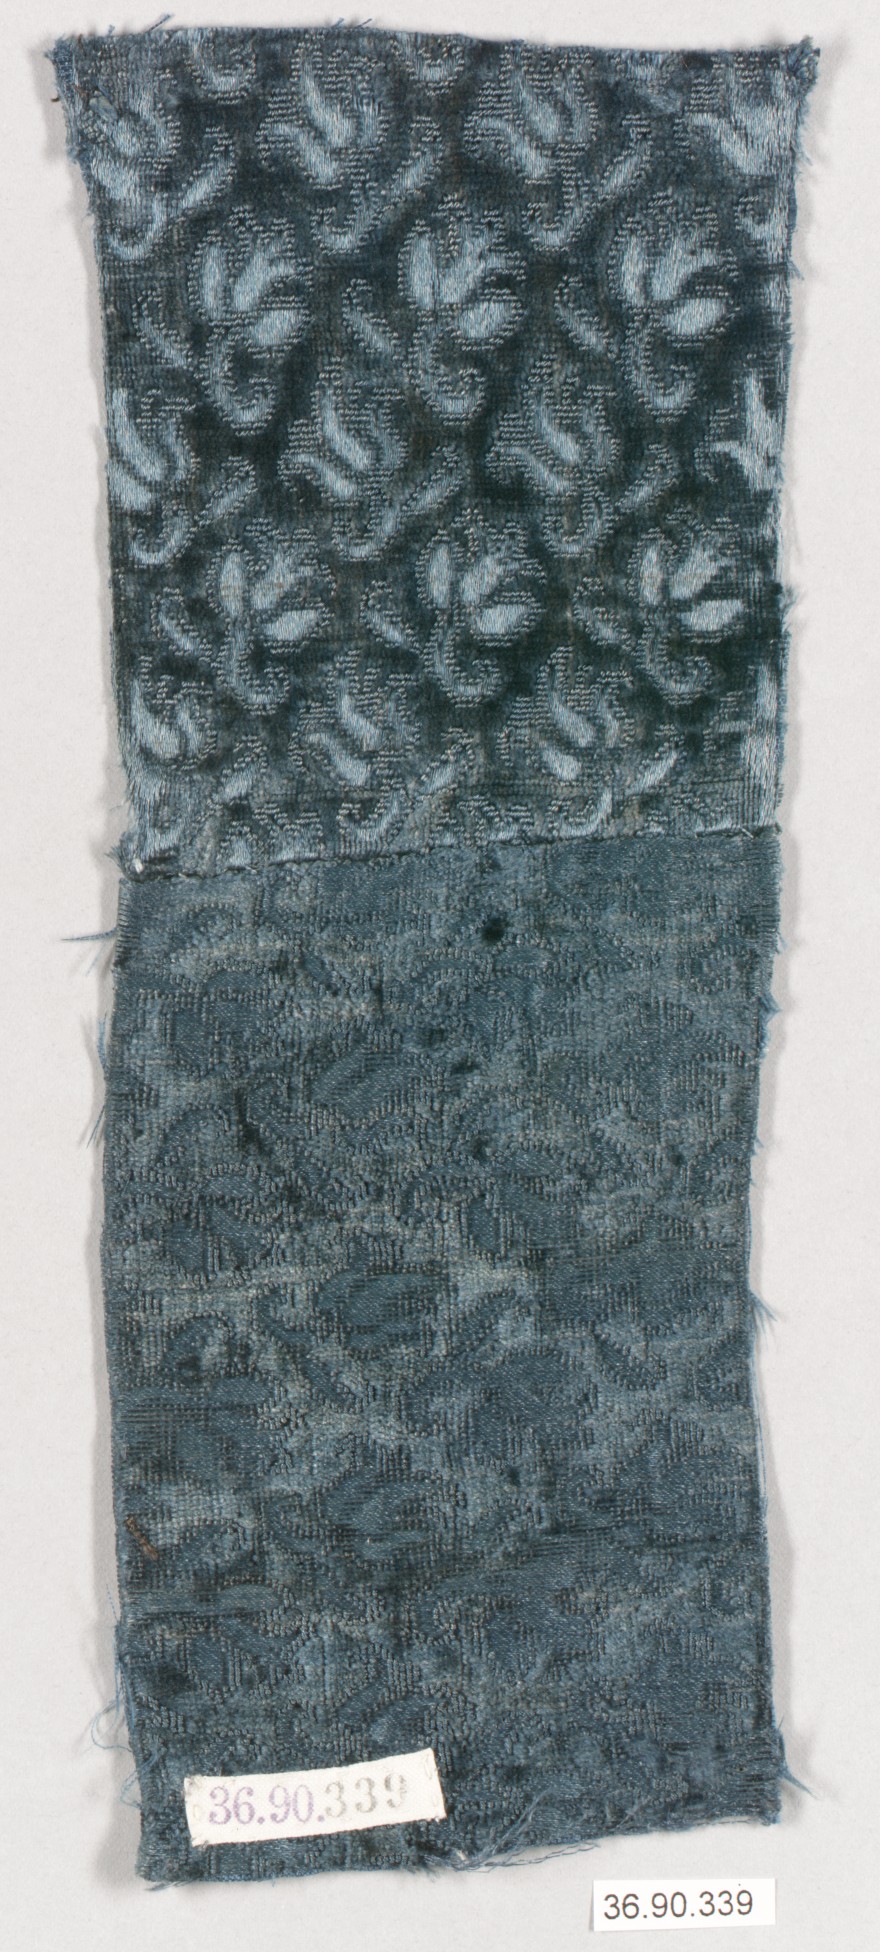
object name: piece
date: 1501-1700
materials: silk